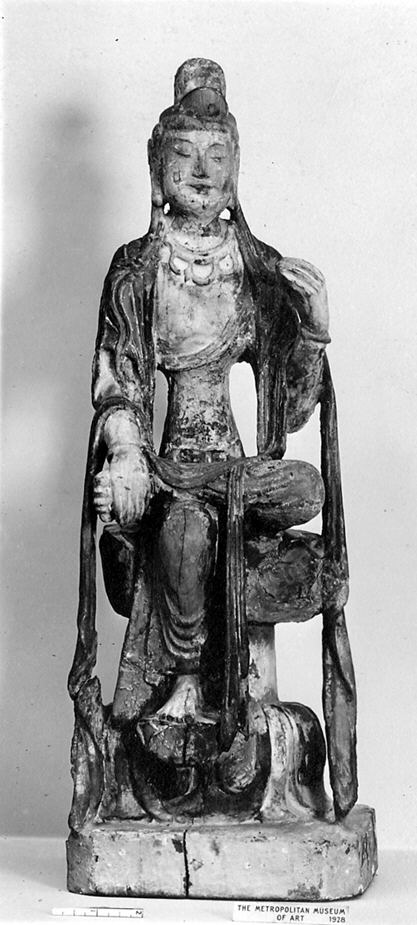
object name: figure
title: Statuette of Guanyin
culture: chinese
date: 1901-2000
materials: wood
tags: bodhisattvas